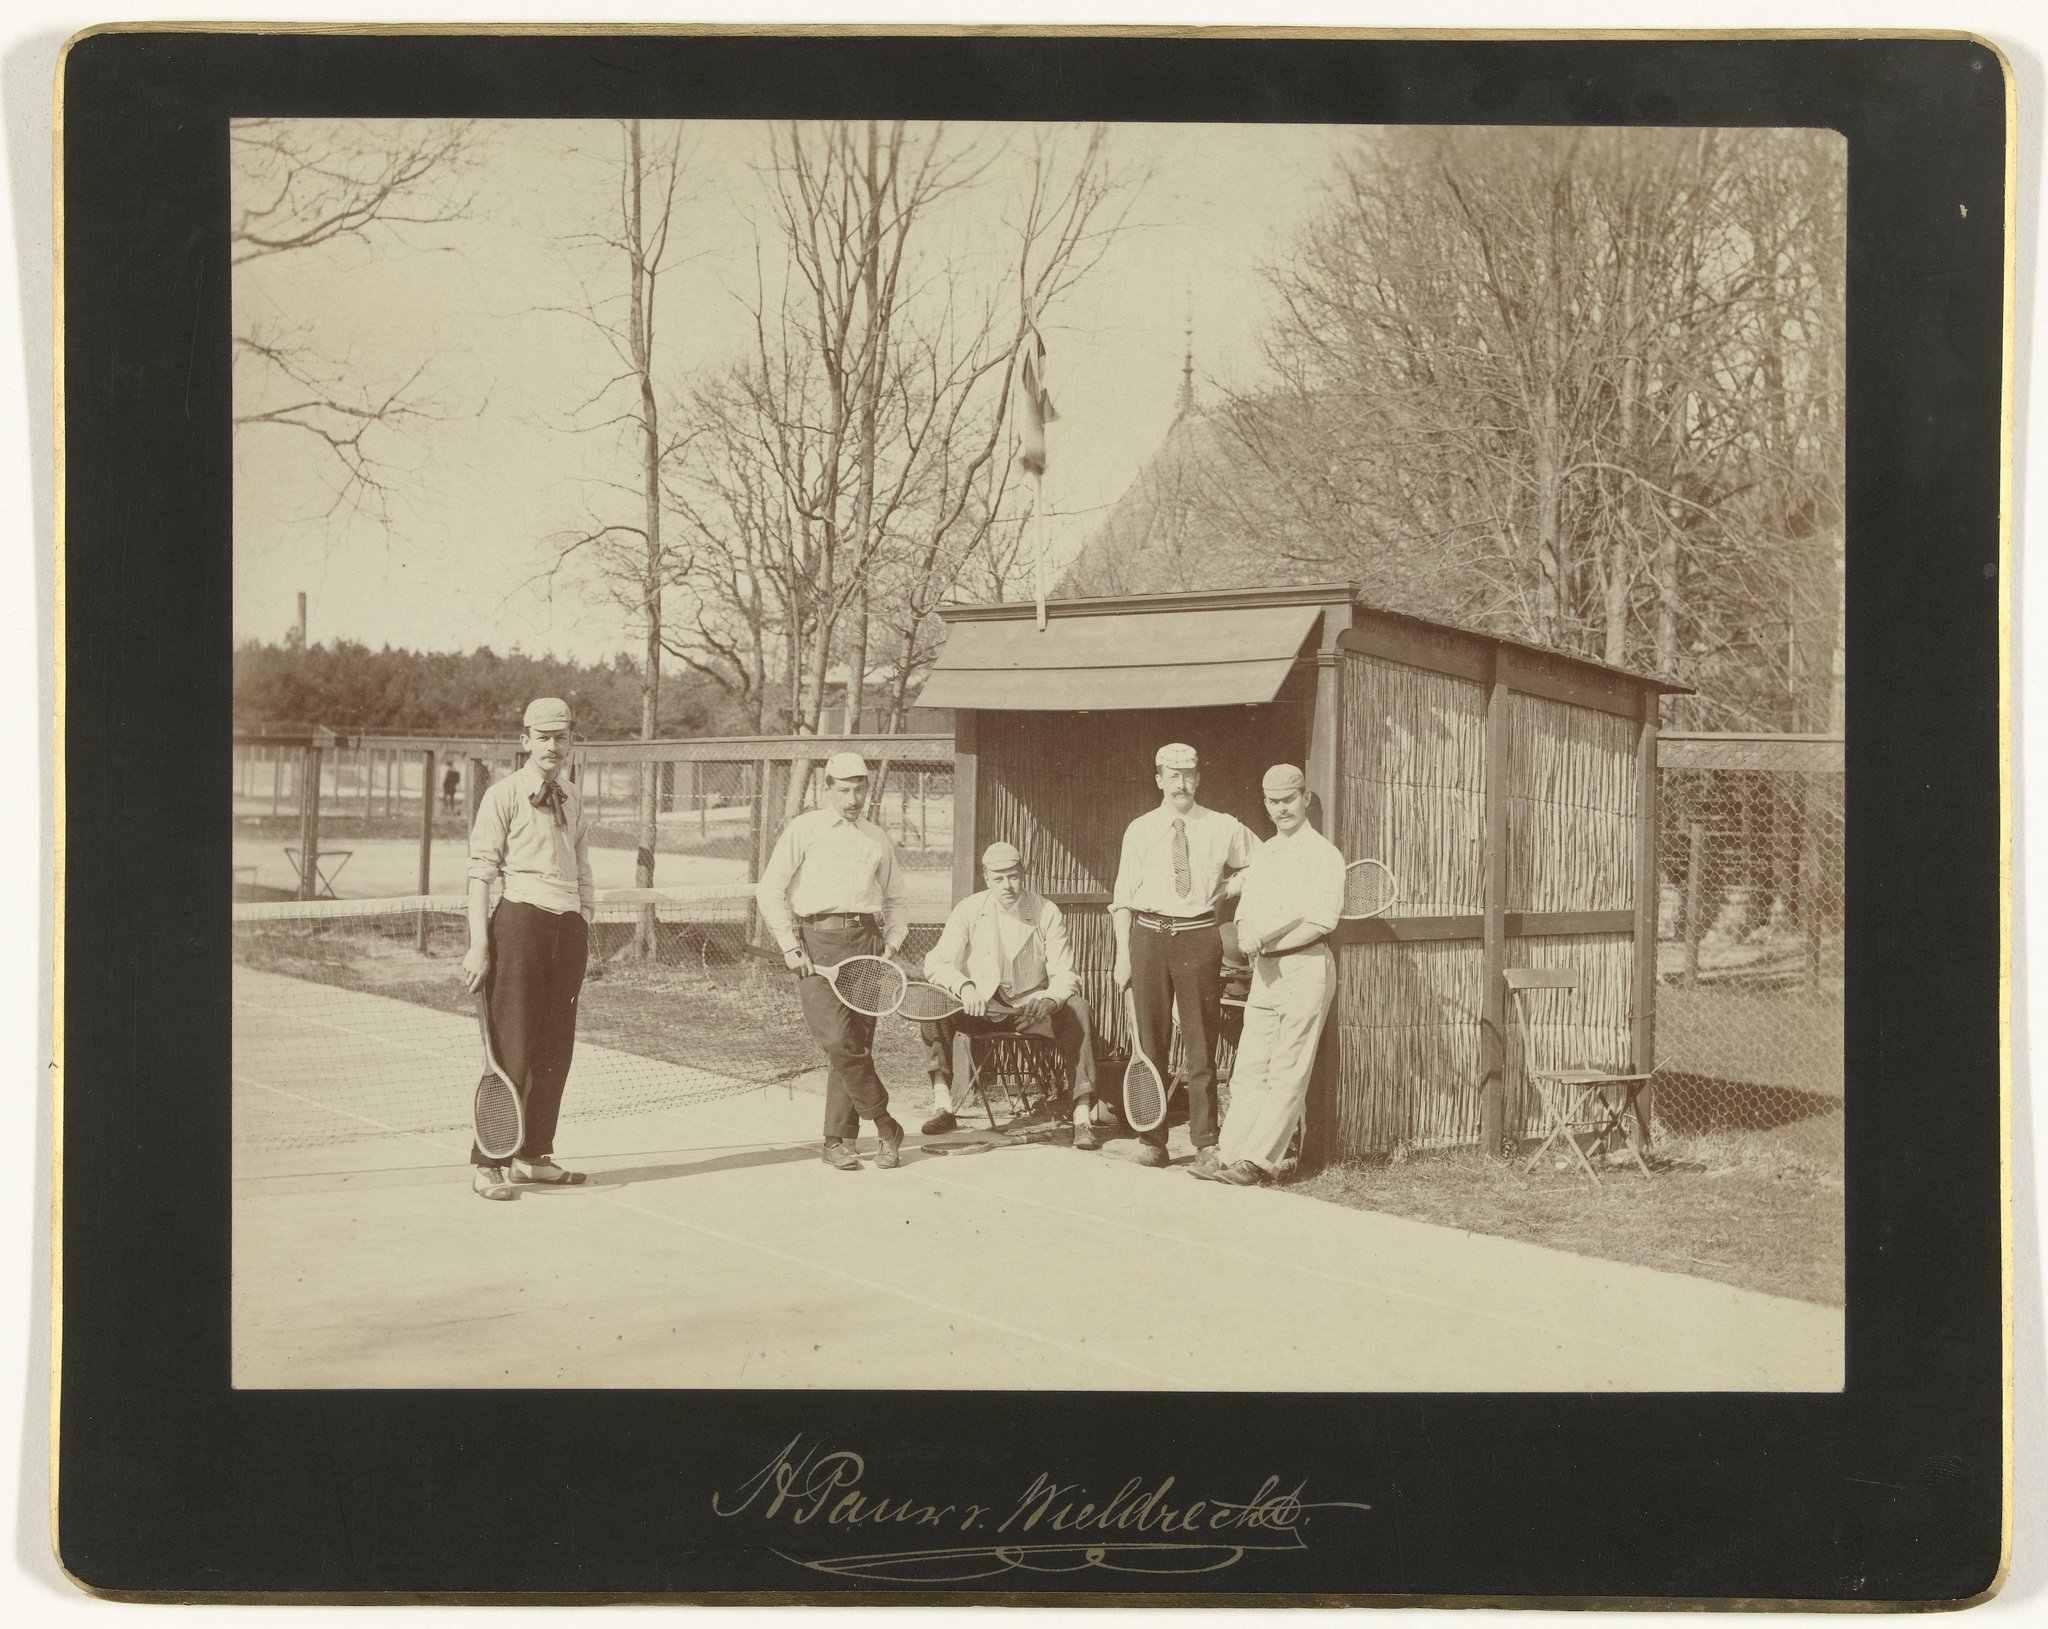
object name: photograph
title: Groepsportret van vijf mannen met tennisrackets op een tennisbaan, tweede van rechts Henry Pauw van Wieldrecht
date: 1892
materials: cardboard, photographic support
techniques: albumen print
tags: henry pauw van wieldrecht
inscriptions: signature: ‘H Pauw v. Wieldrecht’, annotation